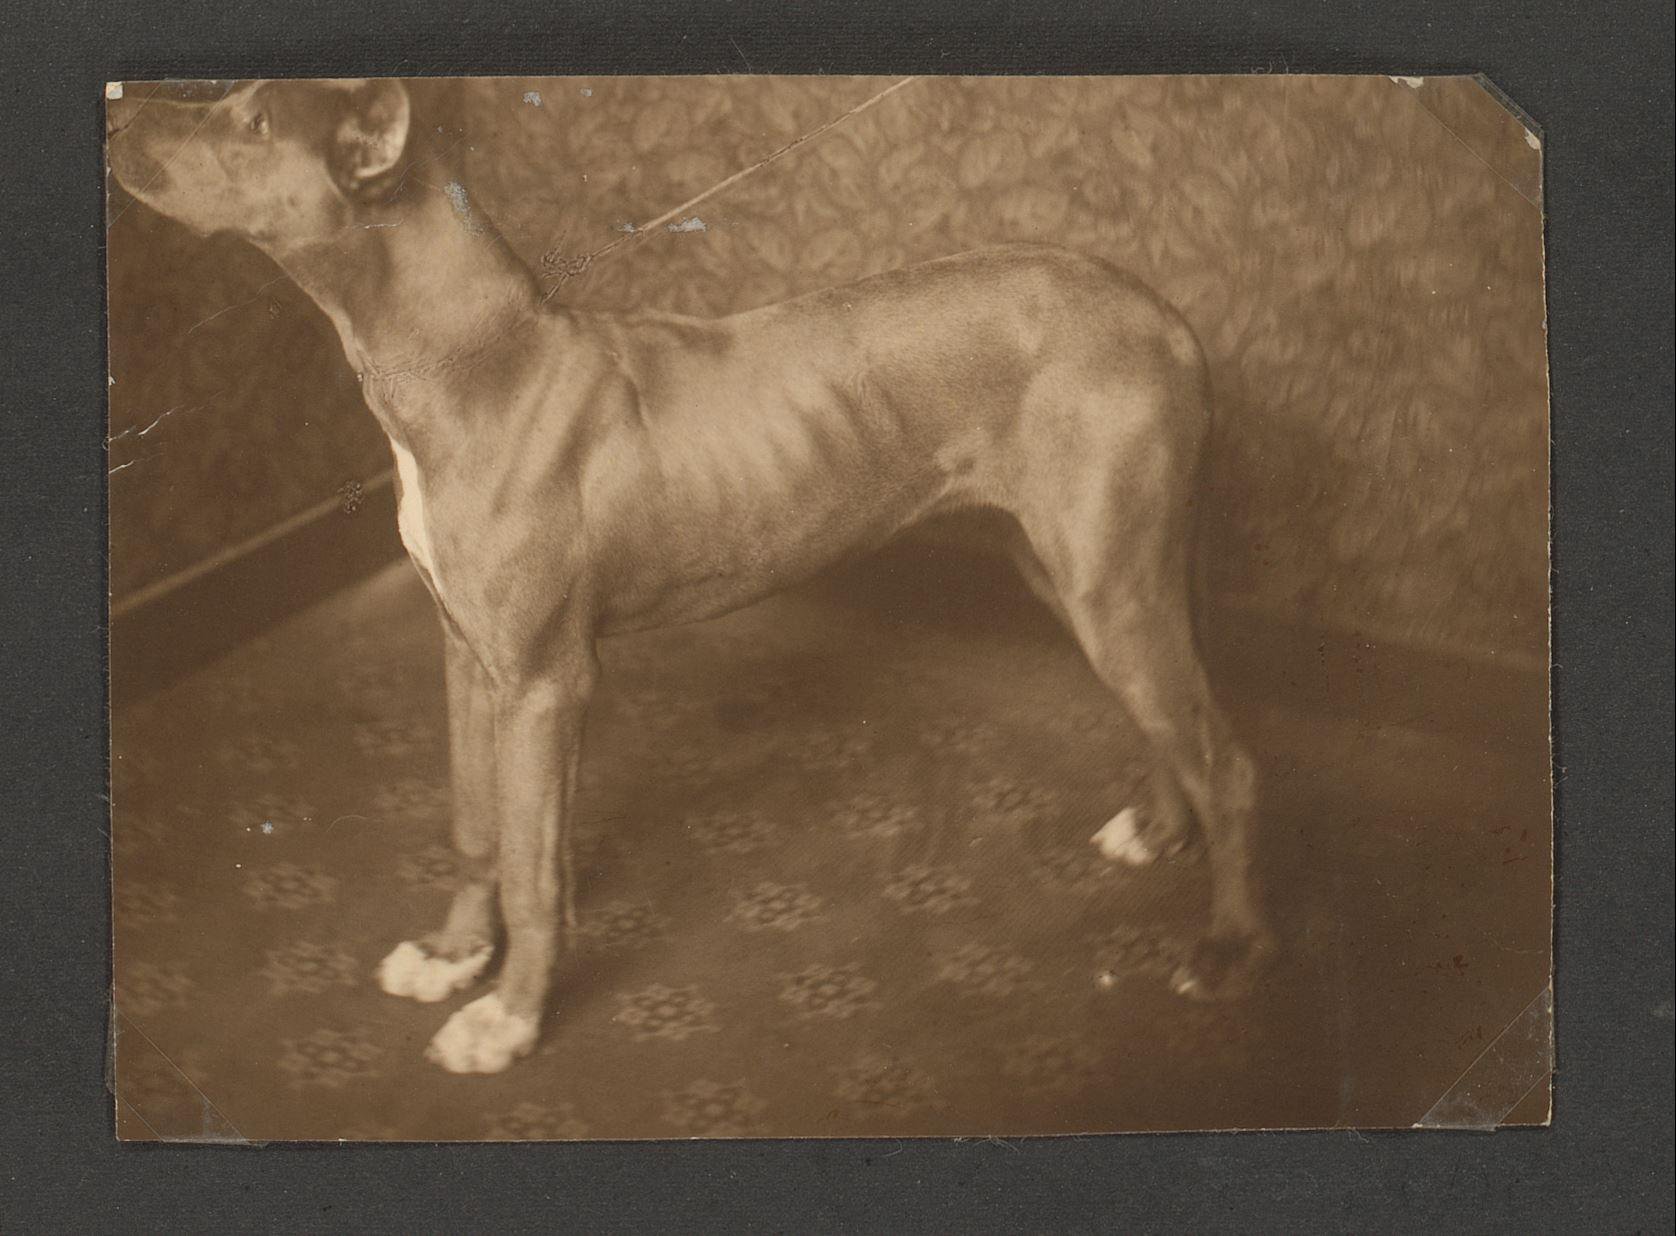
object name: photograph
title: Portret van een hond van de poppendokter in interieur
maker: Anonymous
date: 1930-1940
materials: photographic support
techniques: gelatin silver print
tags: interior of the house, dog